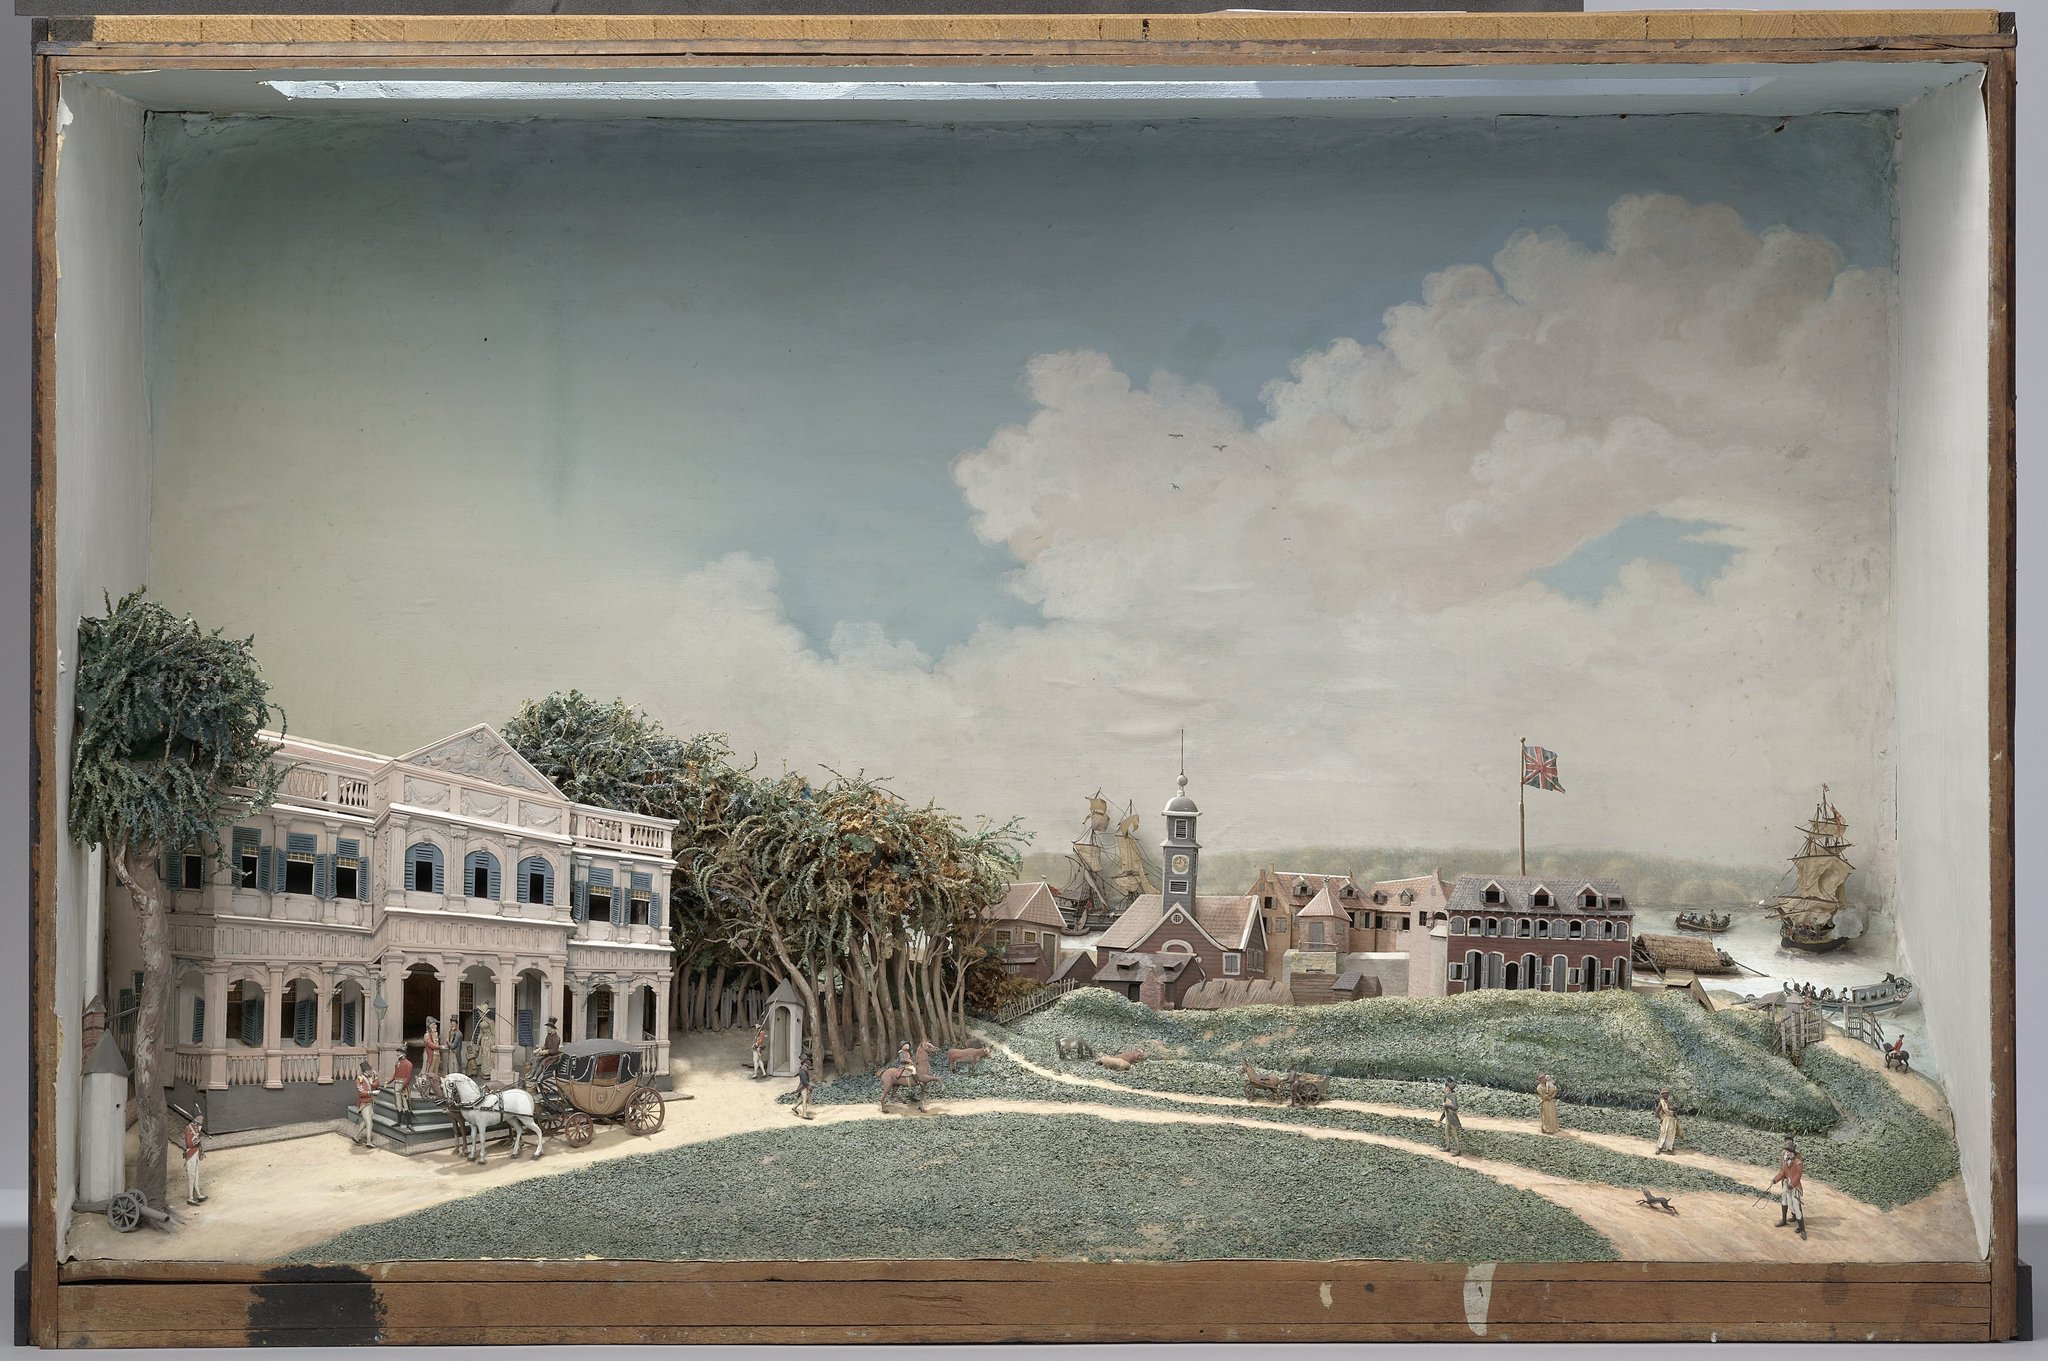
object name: diorama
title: Diorama of Government Square in Paramaribo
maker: gerrit schouten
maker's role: draughtsman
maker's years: 1779-1839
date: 1812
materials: glass, glue, paint, paper, wood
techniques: woodworking, molding, painting, sawing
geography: suriname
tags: sailing-ship, sailing-boat, city-view in general; 'veduta', (military) uniforms, four-wheeled vehicle drawn by two animals, colonial government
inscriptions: inscription: ‘A View of the Gouvernment House and Parade Ground in the Colony of Surinam, and part of Fort Zelandia’, signature and date: ‘Door G Schouten / 1812 te Suriname’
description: This is Government Square (now Independence Square) in Paramaribo in the years when Suriname was under British rule (1804-1816). On the path at the right is a woman carrying a child in her arms. Many enslaved women had to give up caring for their own families to feed and raise the slave owner’s children. Once they reached adulthood, these children in turn became the ‘owners’ of their former caretakers.